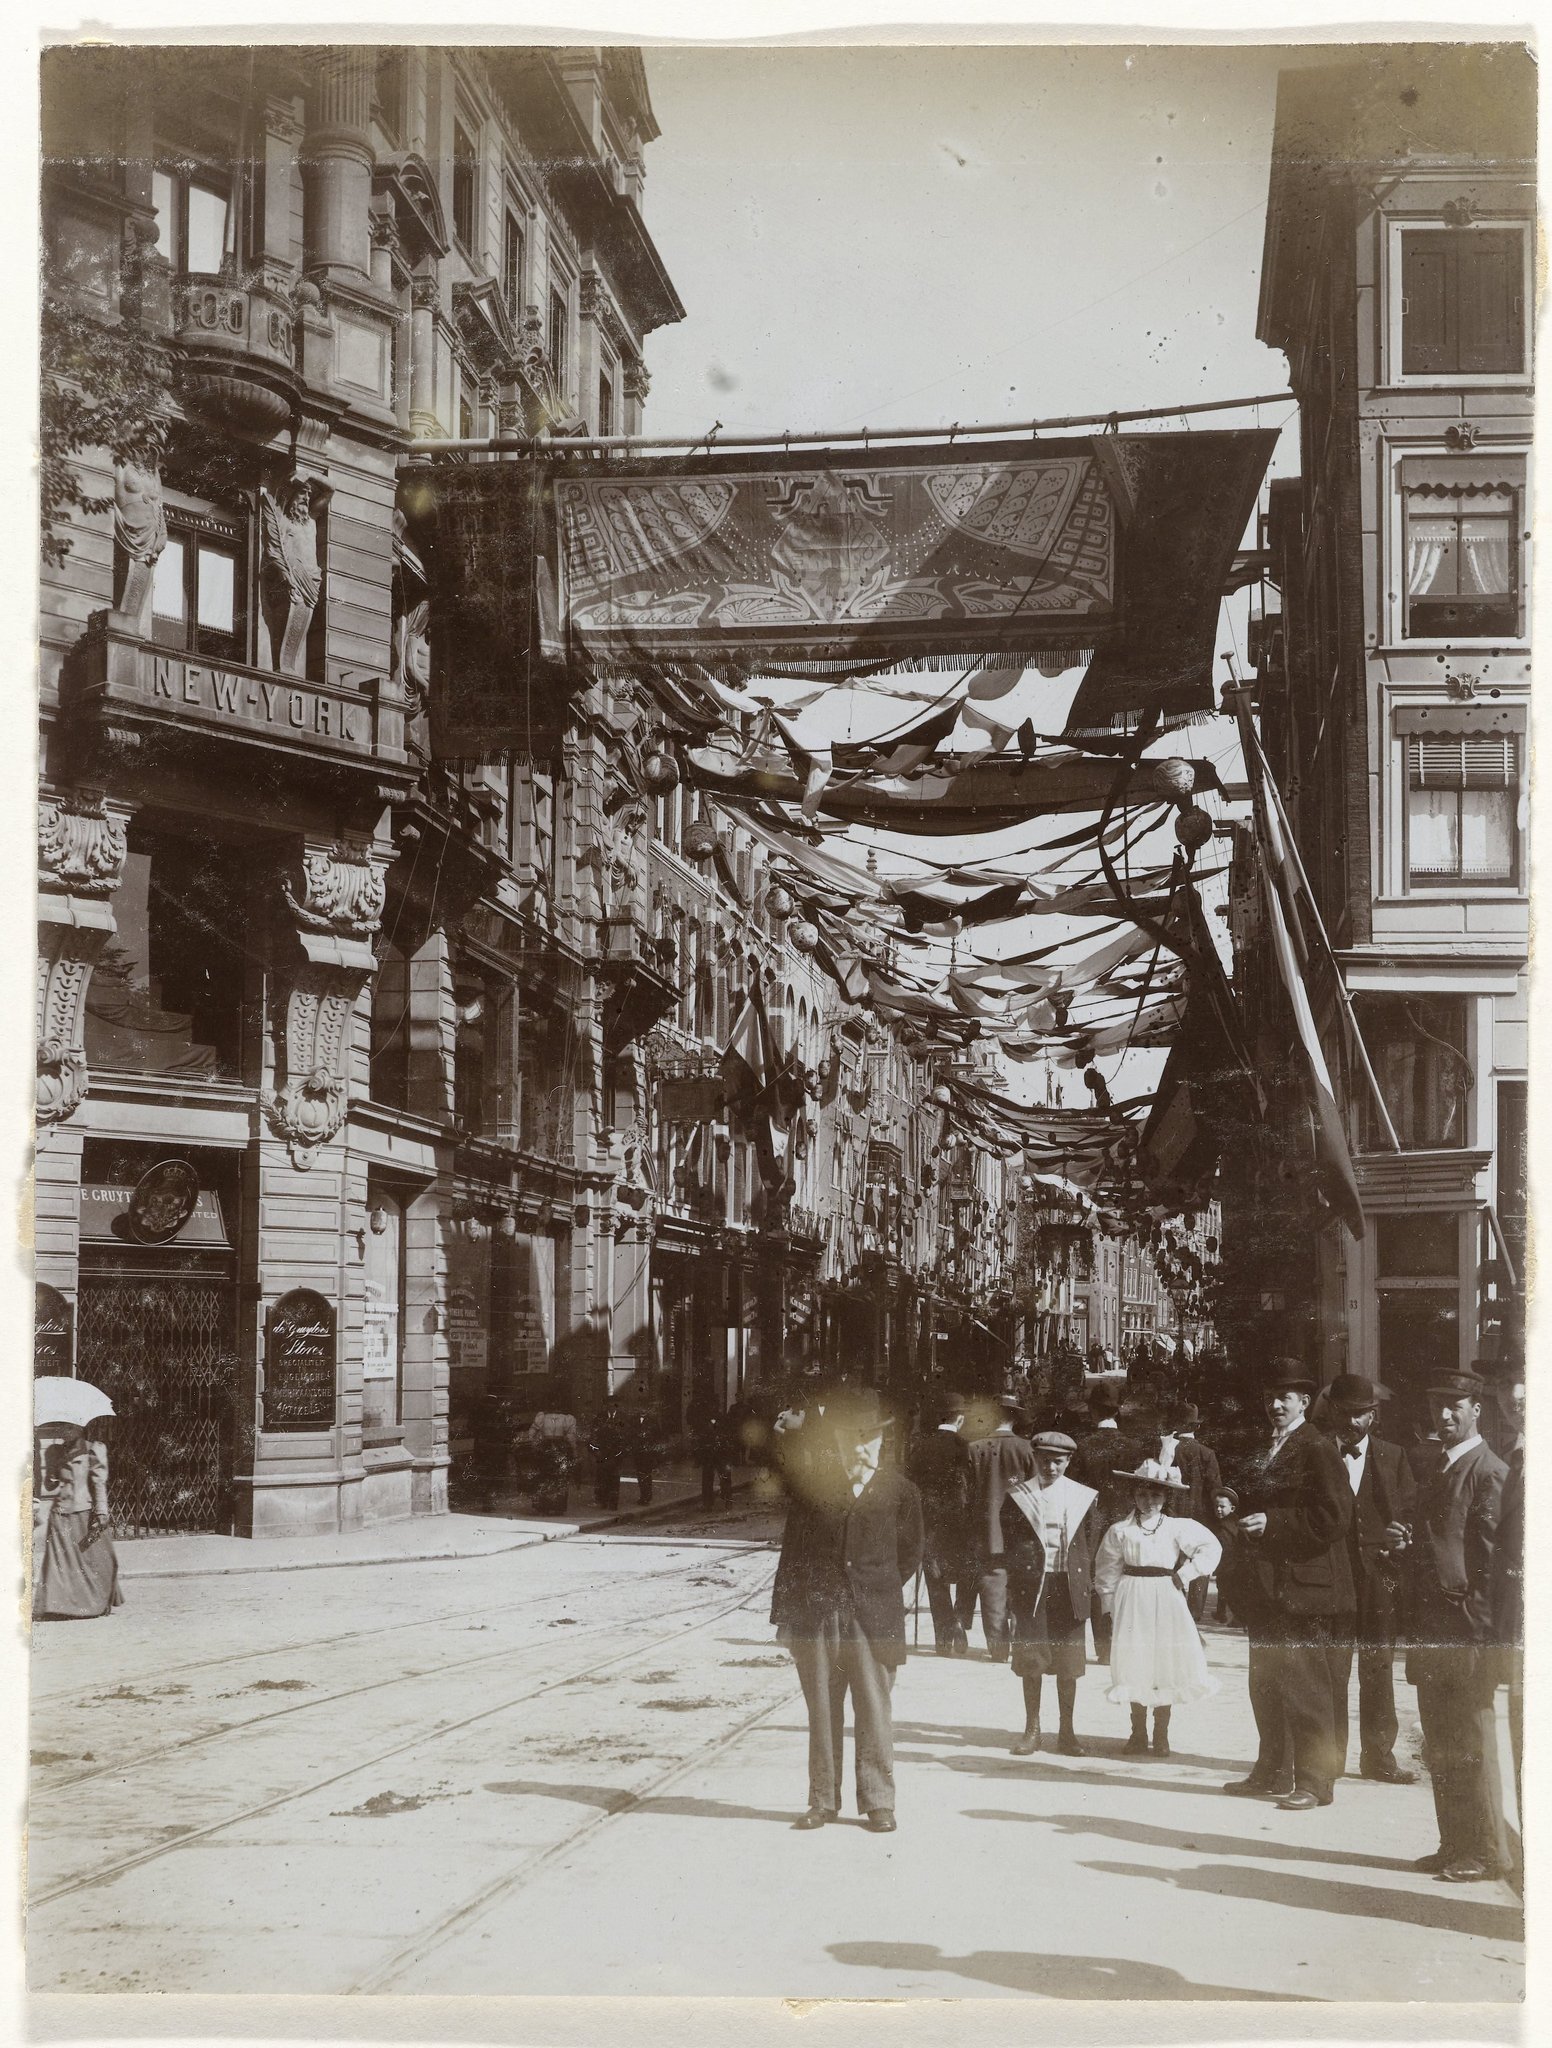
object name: photograph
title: Gezicht op de Leidsestraat ter hoogte van de Keizersgracht, versierd ter gelegenheid van de inhuldiging van koningin Wilhelmina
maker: Anonymous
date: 1809-1898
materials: paper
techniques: collodion silver print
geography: amsterdam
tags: public festivities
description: Gezicht op de Leidsestraat met op de hoek van de Keizersgracht het gebouw van de New York Life Insurance Company, op de begane grond de reiswarenwinkel van Ferdinand Arnold Ludwig de Gruyter.